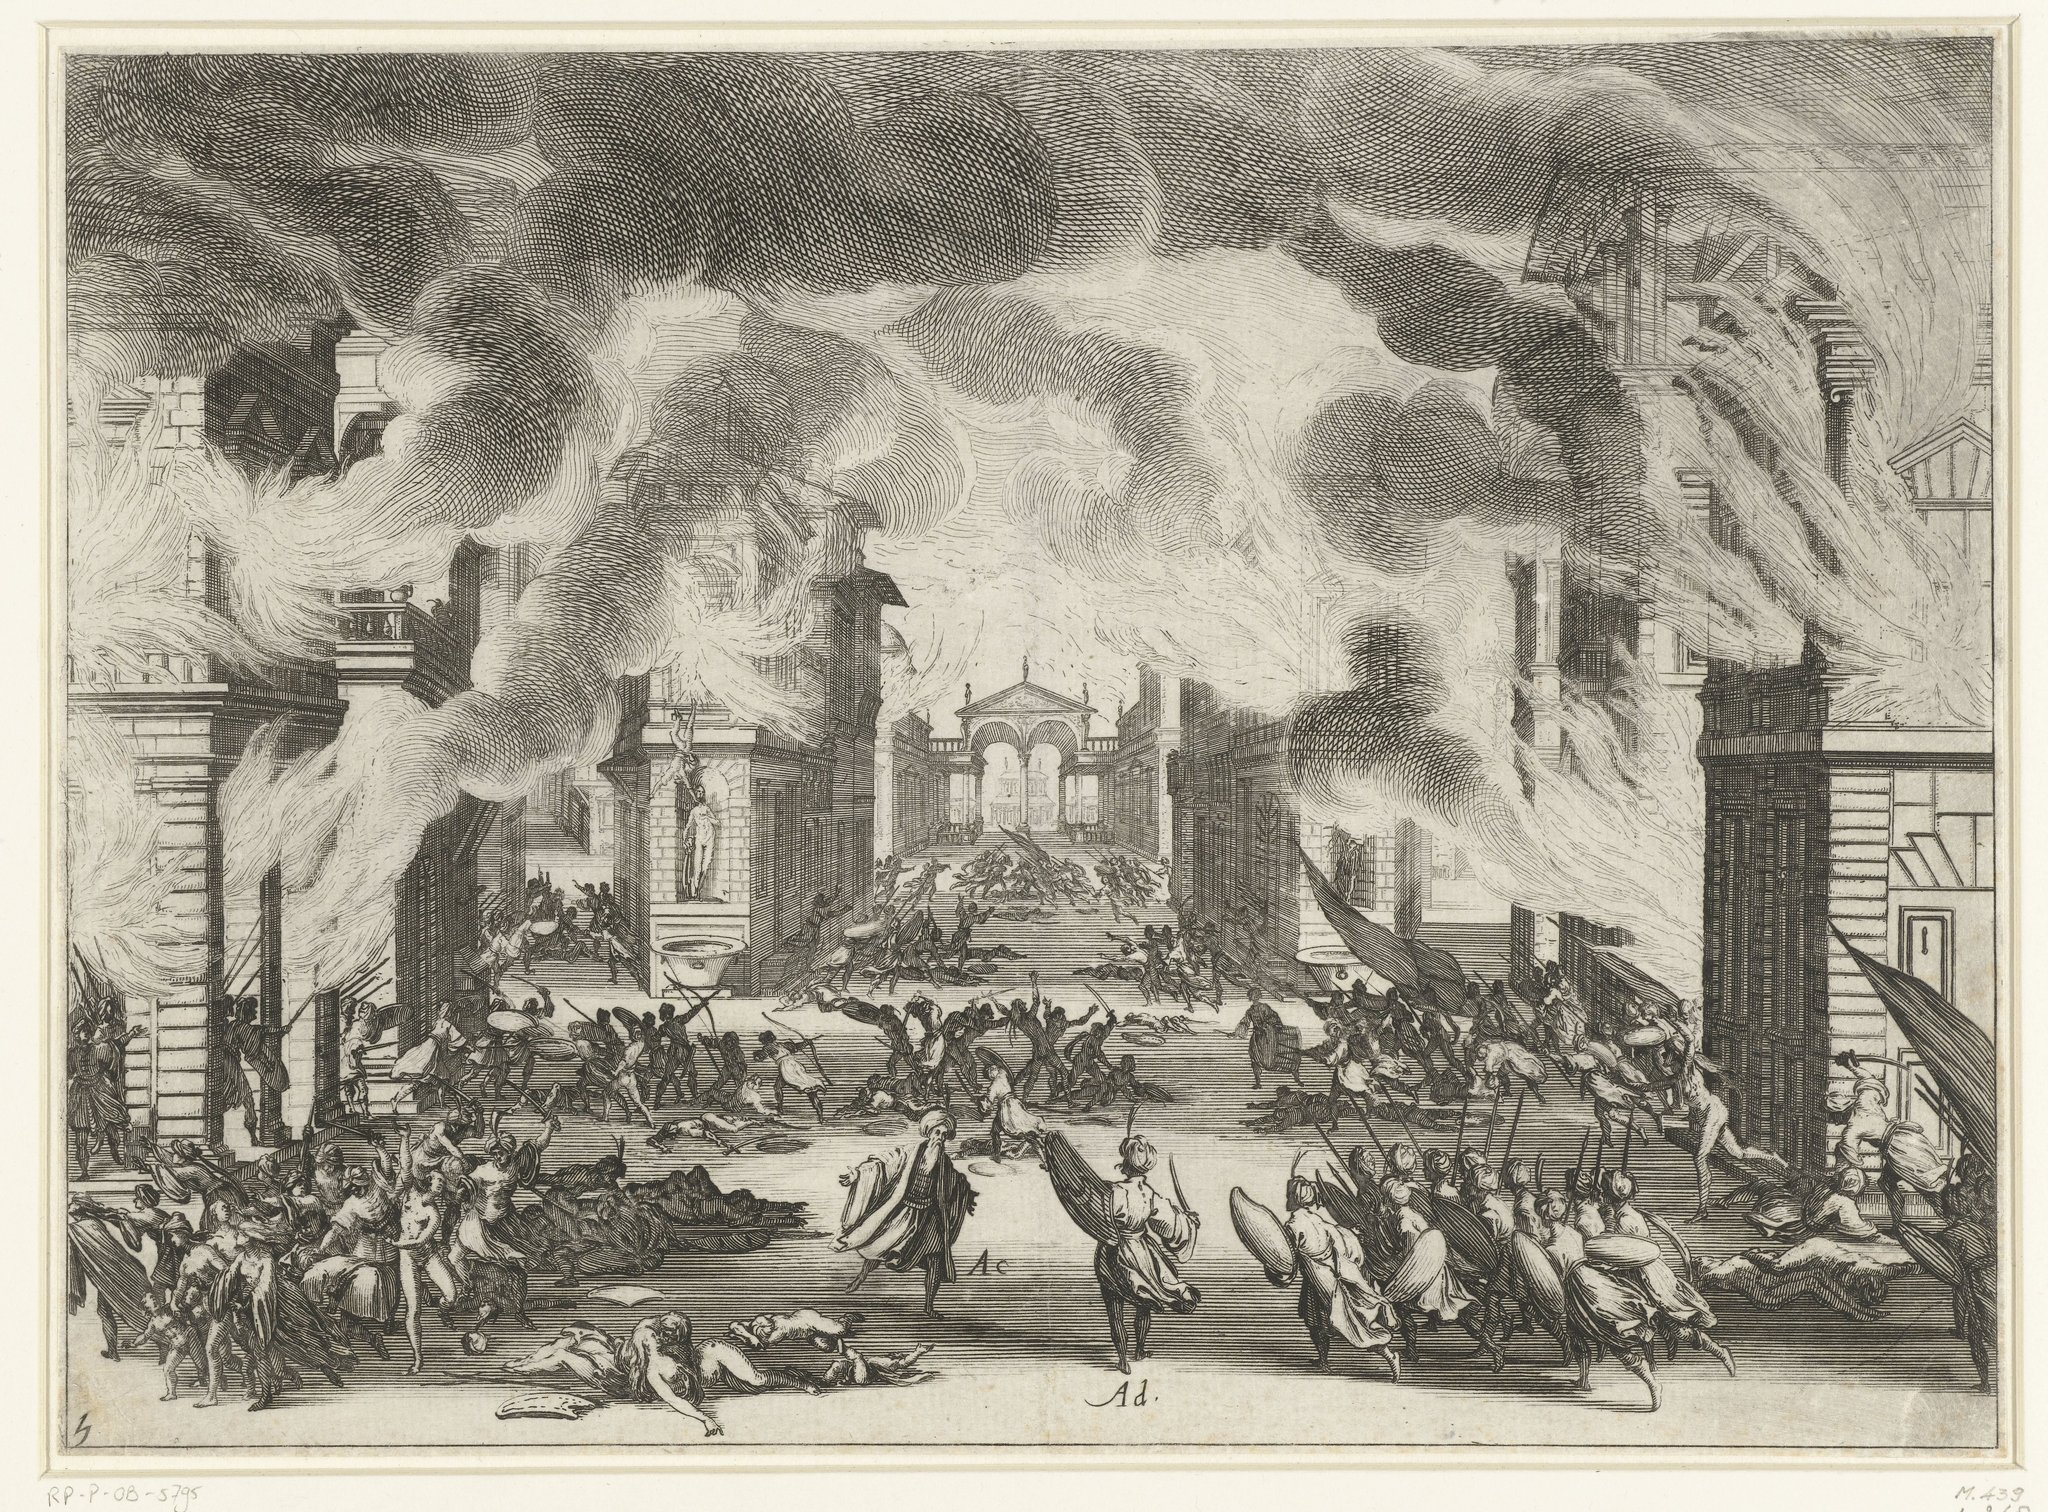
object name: print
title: Illustratie bij de vijfde acte van de tragedie 'Il Solimano'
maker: jacques callot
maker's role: draughtsman, print maker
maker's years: 1592-1635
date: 1619-1620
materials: paper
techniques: engraving, etching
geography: florence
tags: on fire, ablaze, asiatic races and peoples: turks, street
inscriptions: collector's mark: Lugt 240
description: Op een plein of brede straat met grote gebouwen die in brand staan, lopen twee oosters geklede figuren met korte aanduidingen van hun namen bij hun voeten (personages in de tragedie 'Il Solimano'), omgeven door vele overige acteurs, die vechten, plunderen of vluchten.